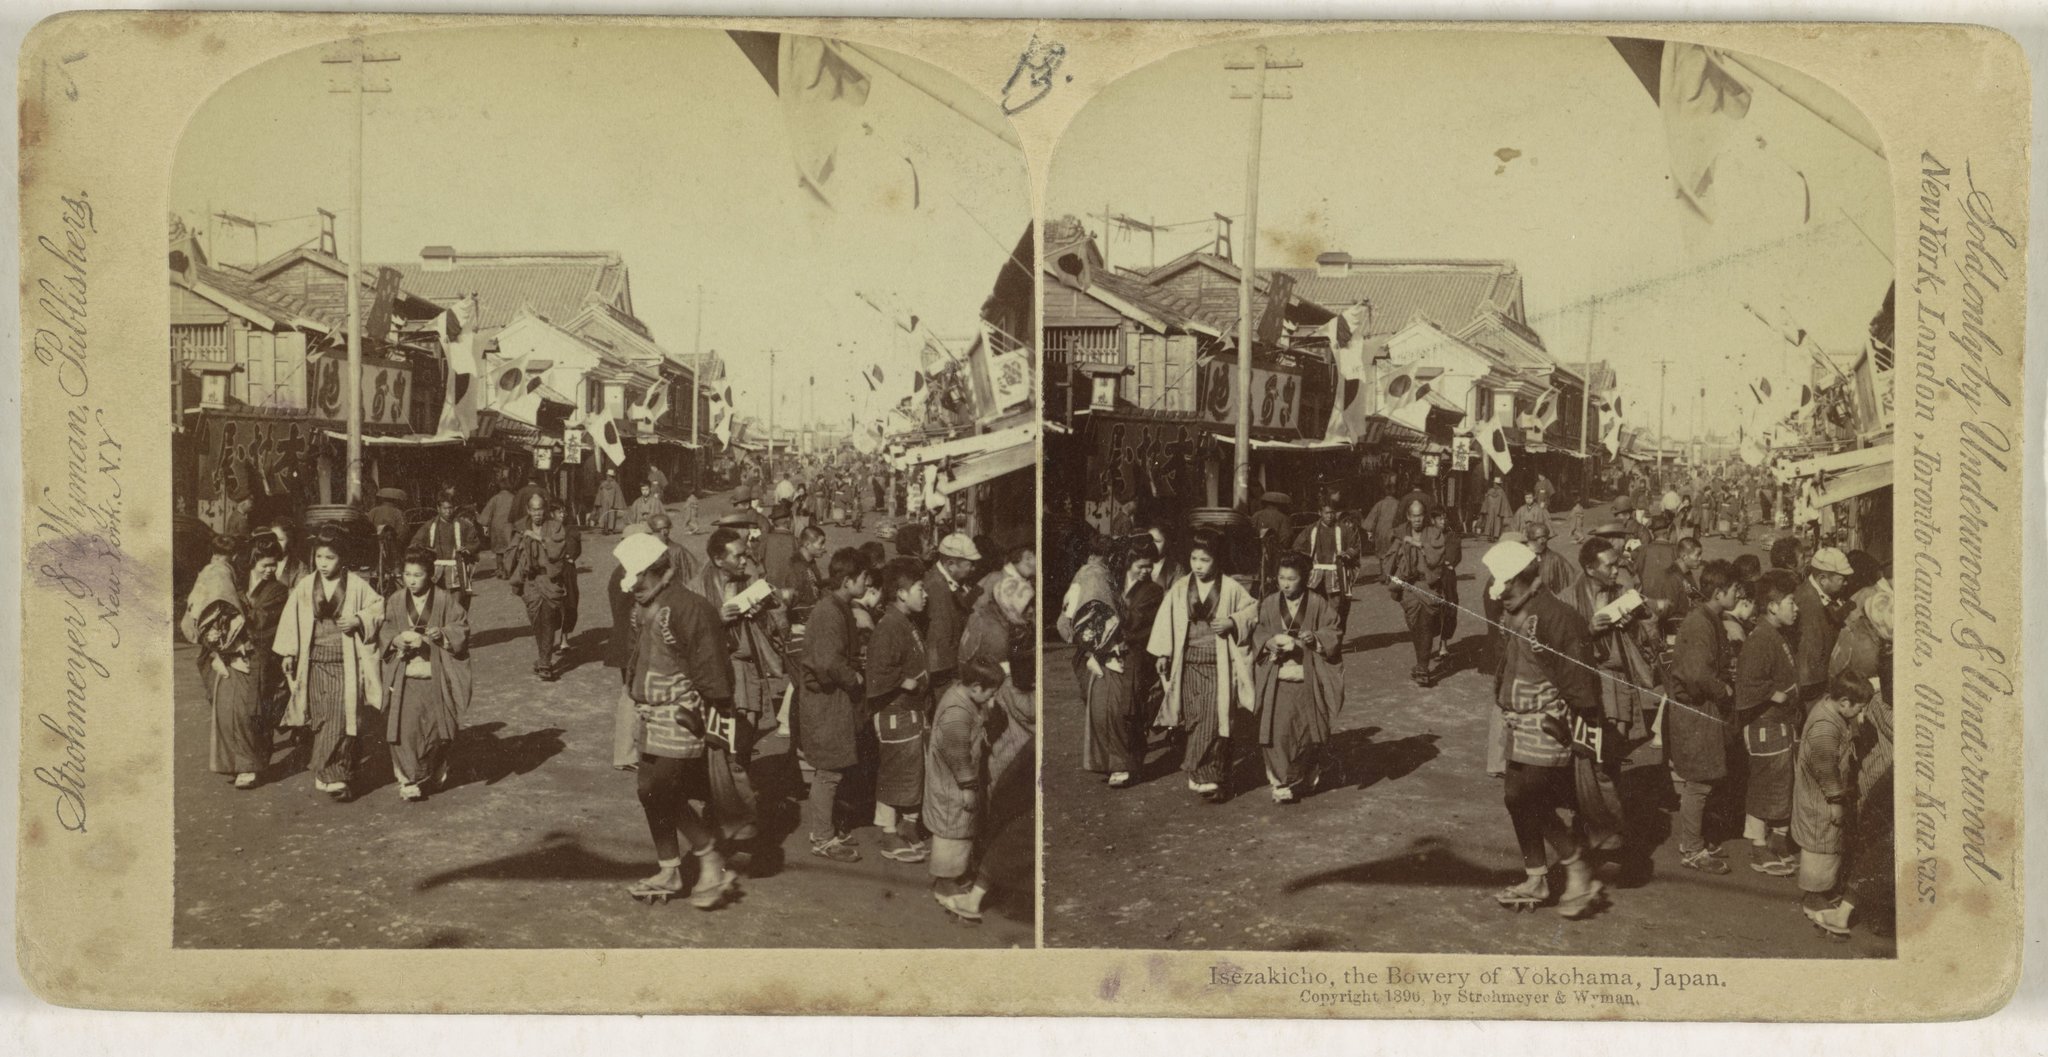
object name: stereograph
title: Isezakicho, the Bowery of Yokohama, Japan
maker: Anonymous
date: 1896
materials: cardboard, paper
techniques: albumen print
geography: new york city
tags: street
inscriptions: title: ‘Isezakicho, the Bowery of Yokohama, Japan.’, copyright notice: ‘Copyright 1896, by Strohmeyer & Wyman.’